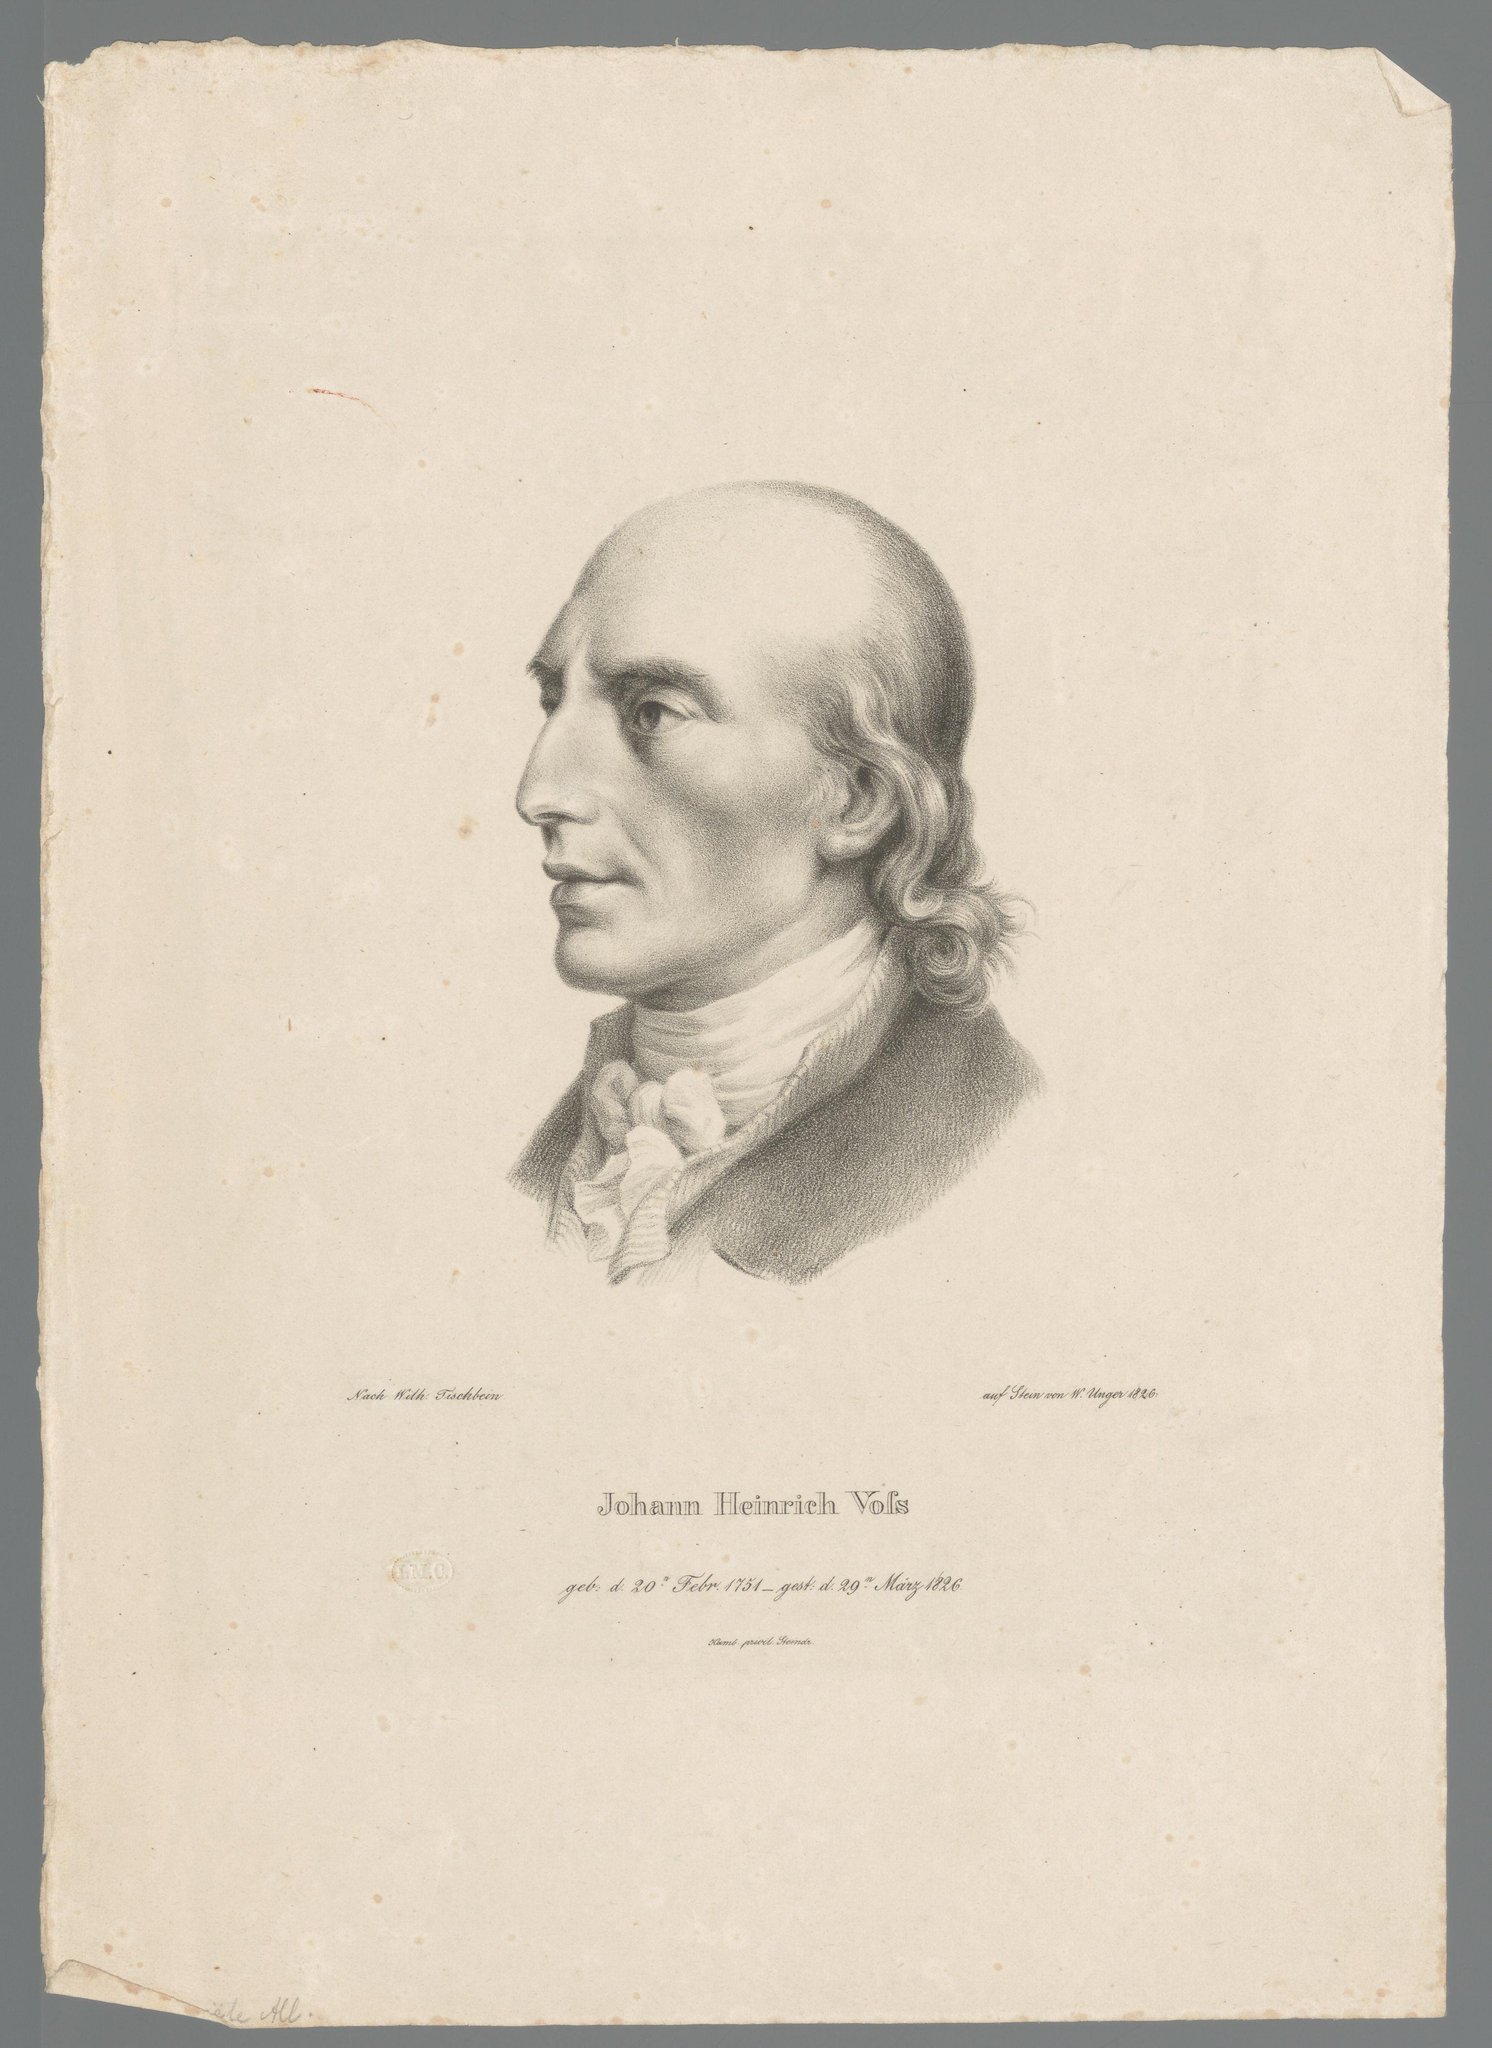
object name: print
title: Johann Heinrich Voss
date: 1826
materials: paper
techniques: lithograph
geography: hamburg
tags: johann heinrich voss, adult man, historical persons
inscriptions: check stamp: ‘I.M.C.’, collector's mark: Lugt 2228